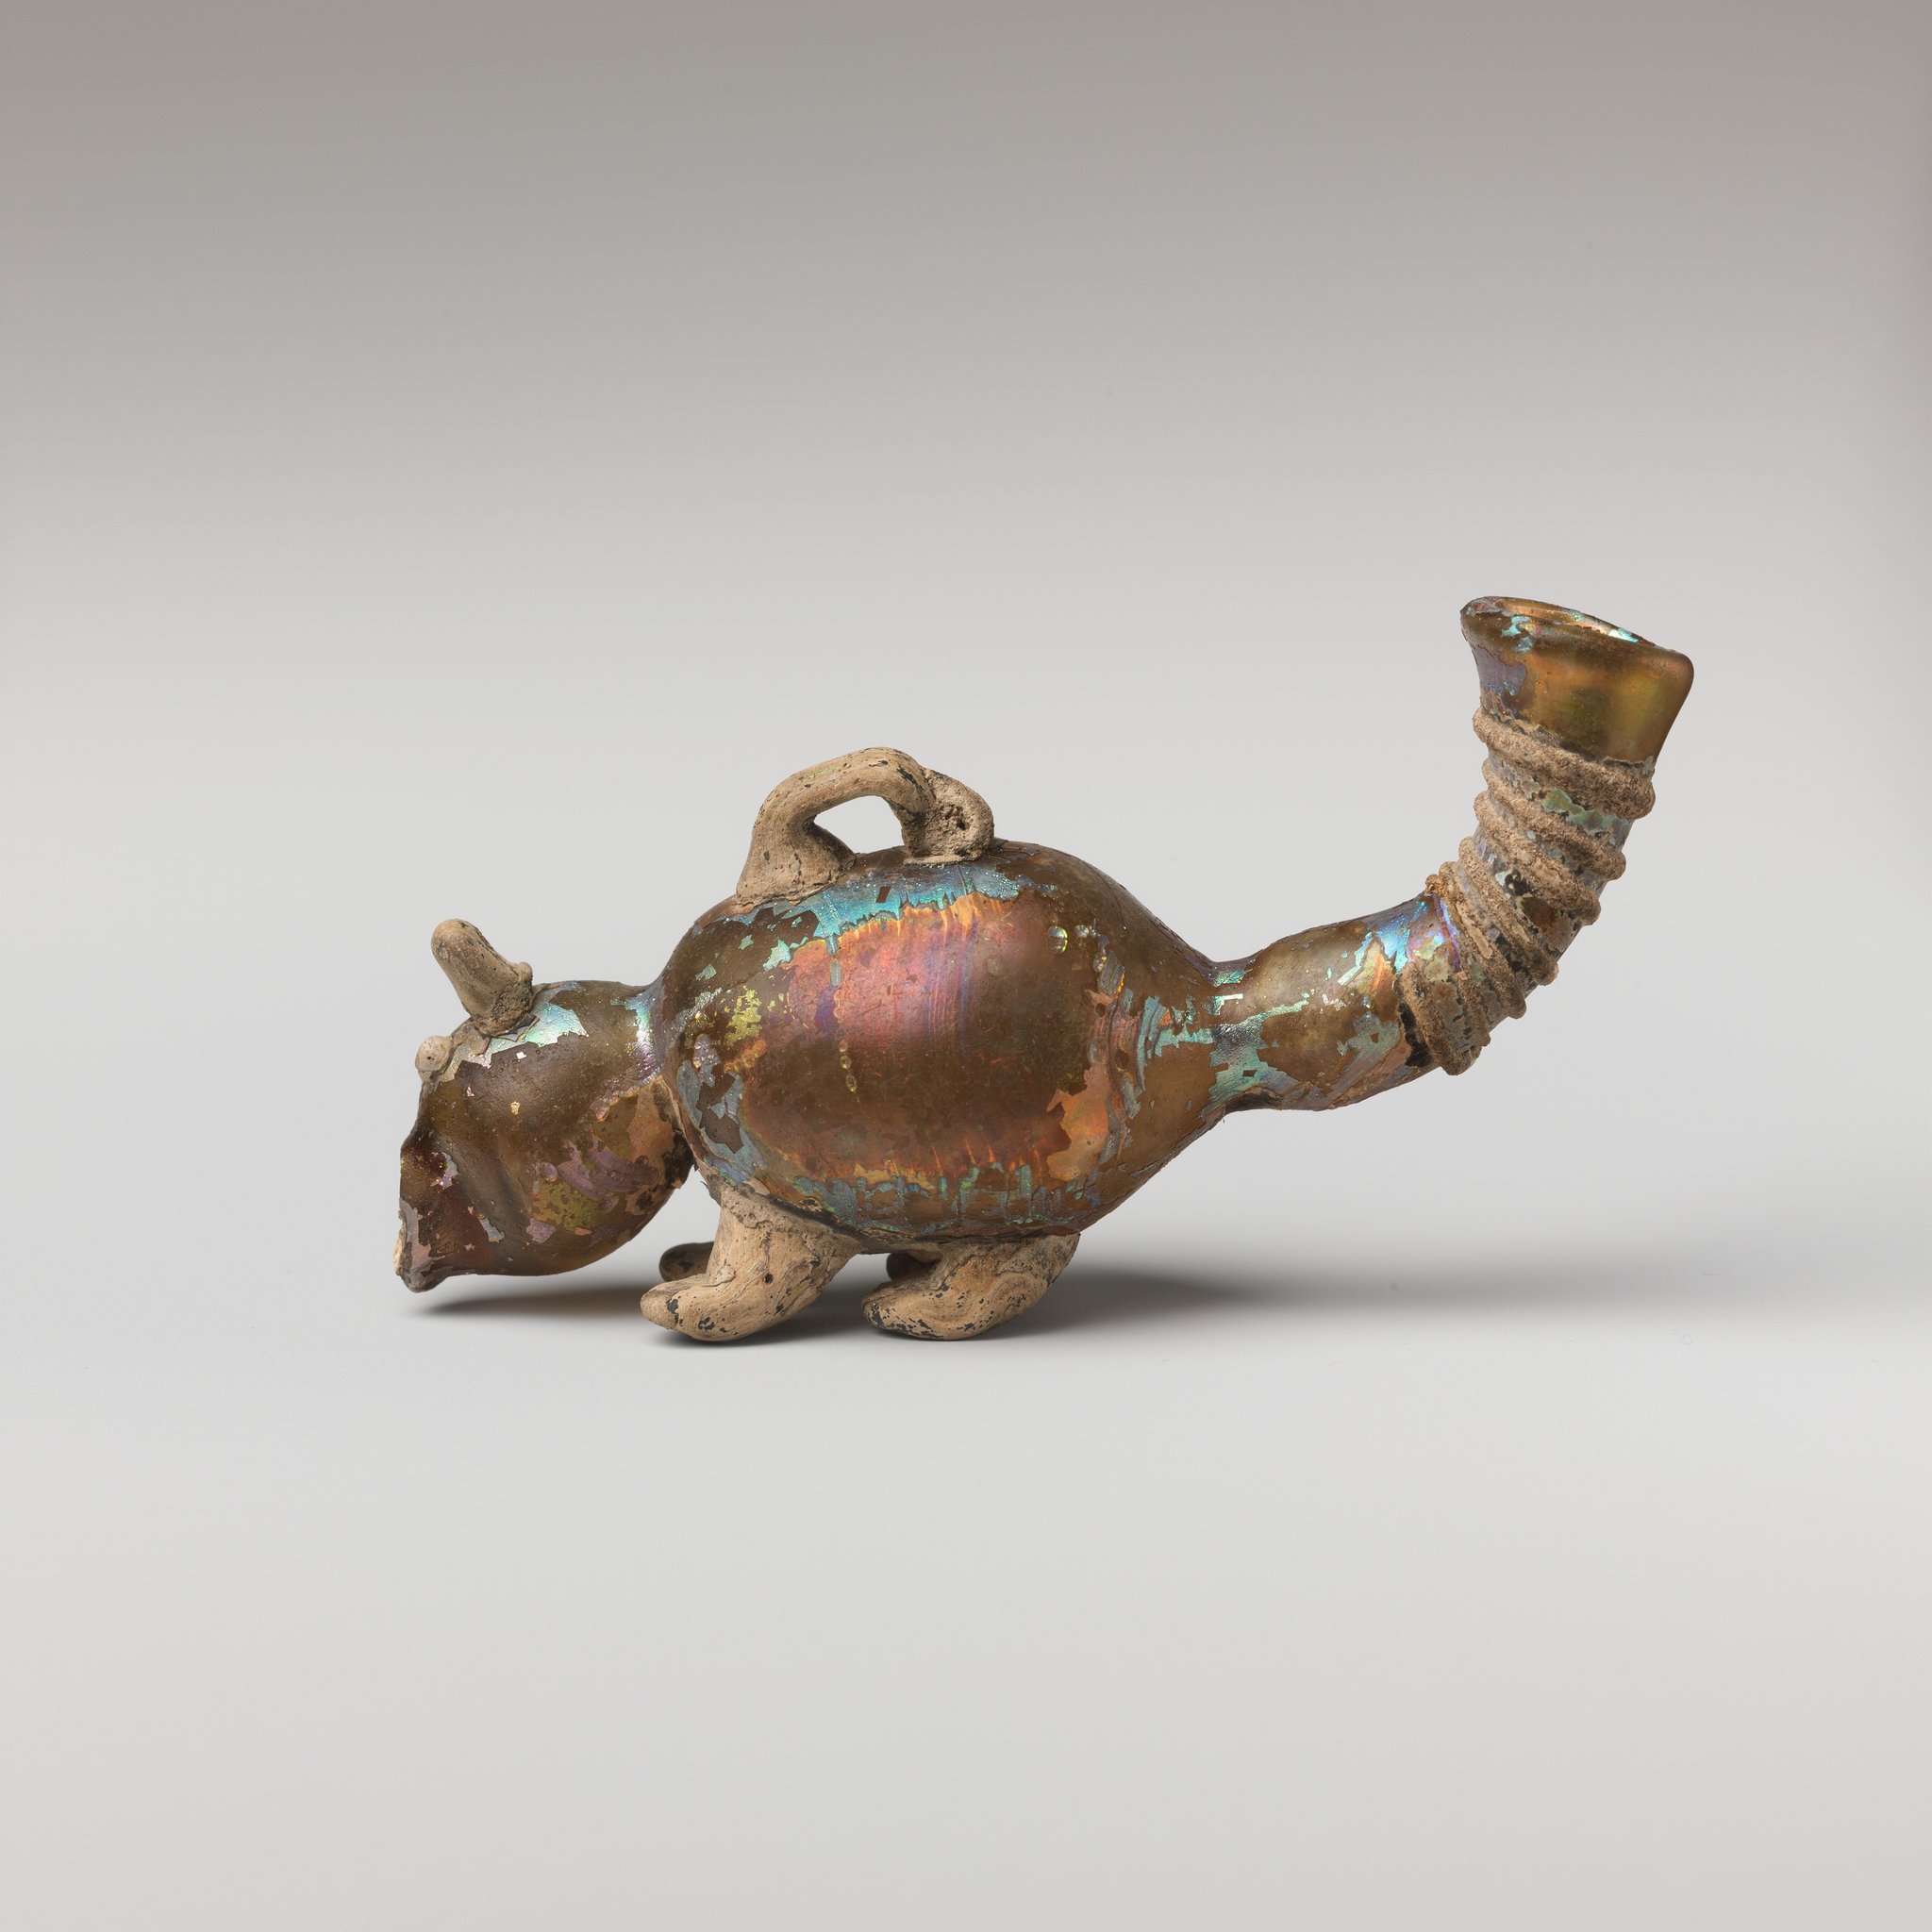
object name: bottle in the form of an animal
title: Glass bottle in the shape of an animal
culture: roman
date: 201-300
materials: glass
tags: animals